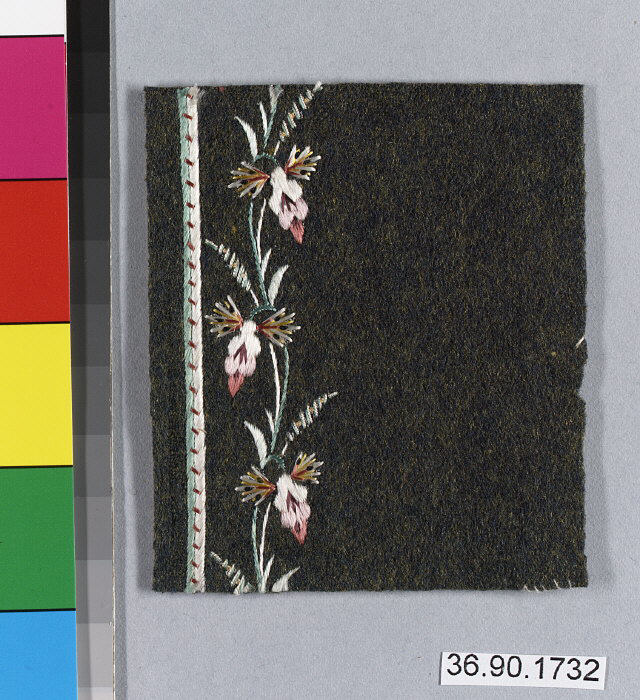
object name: sample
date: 1801-1833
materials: felt, silk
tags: flowers